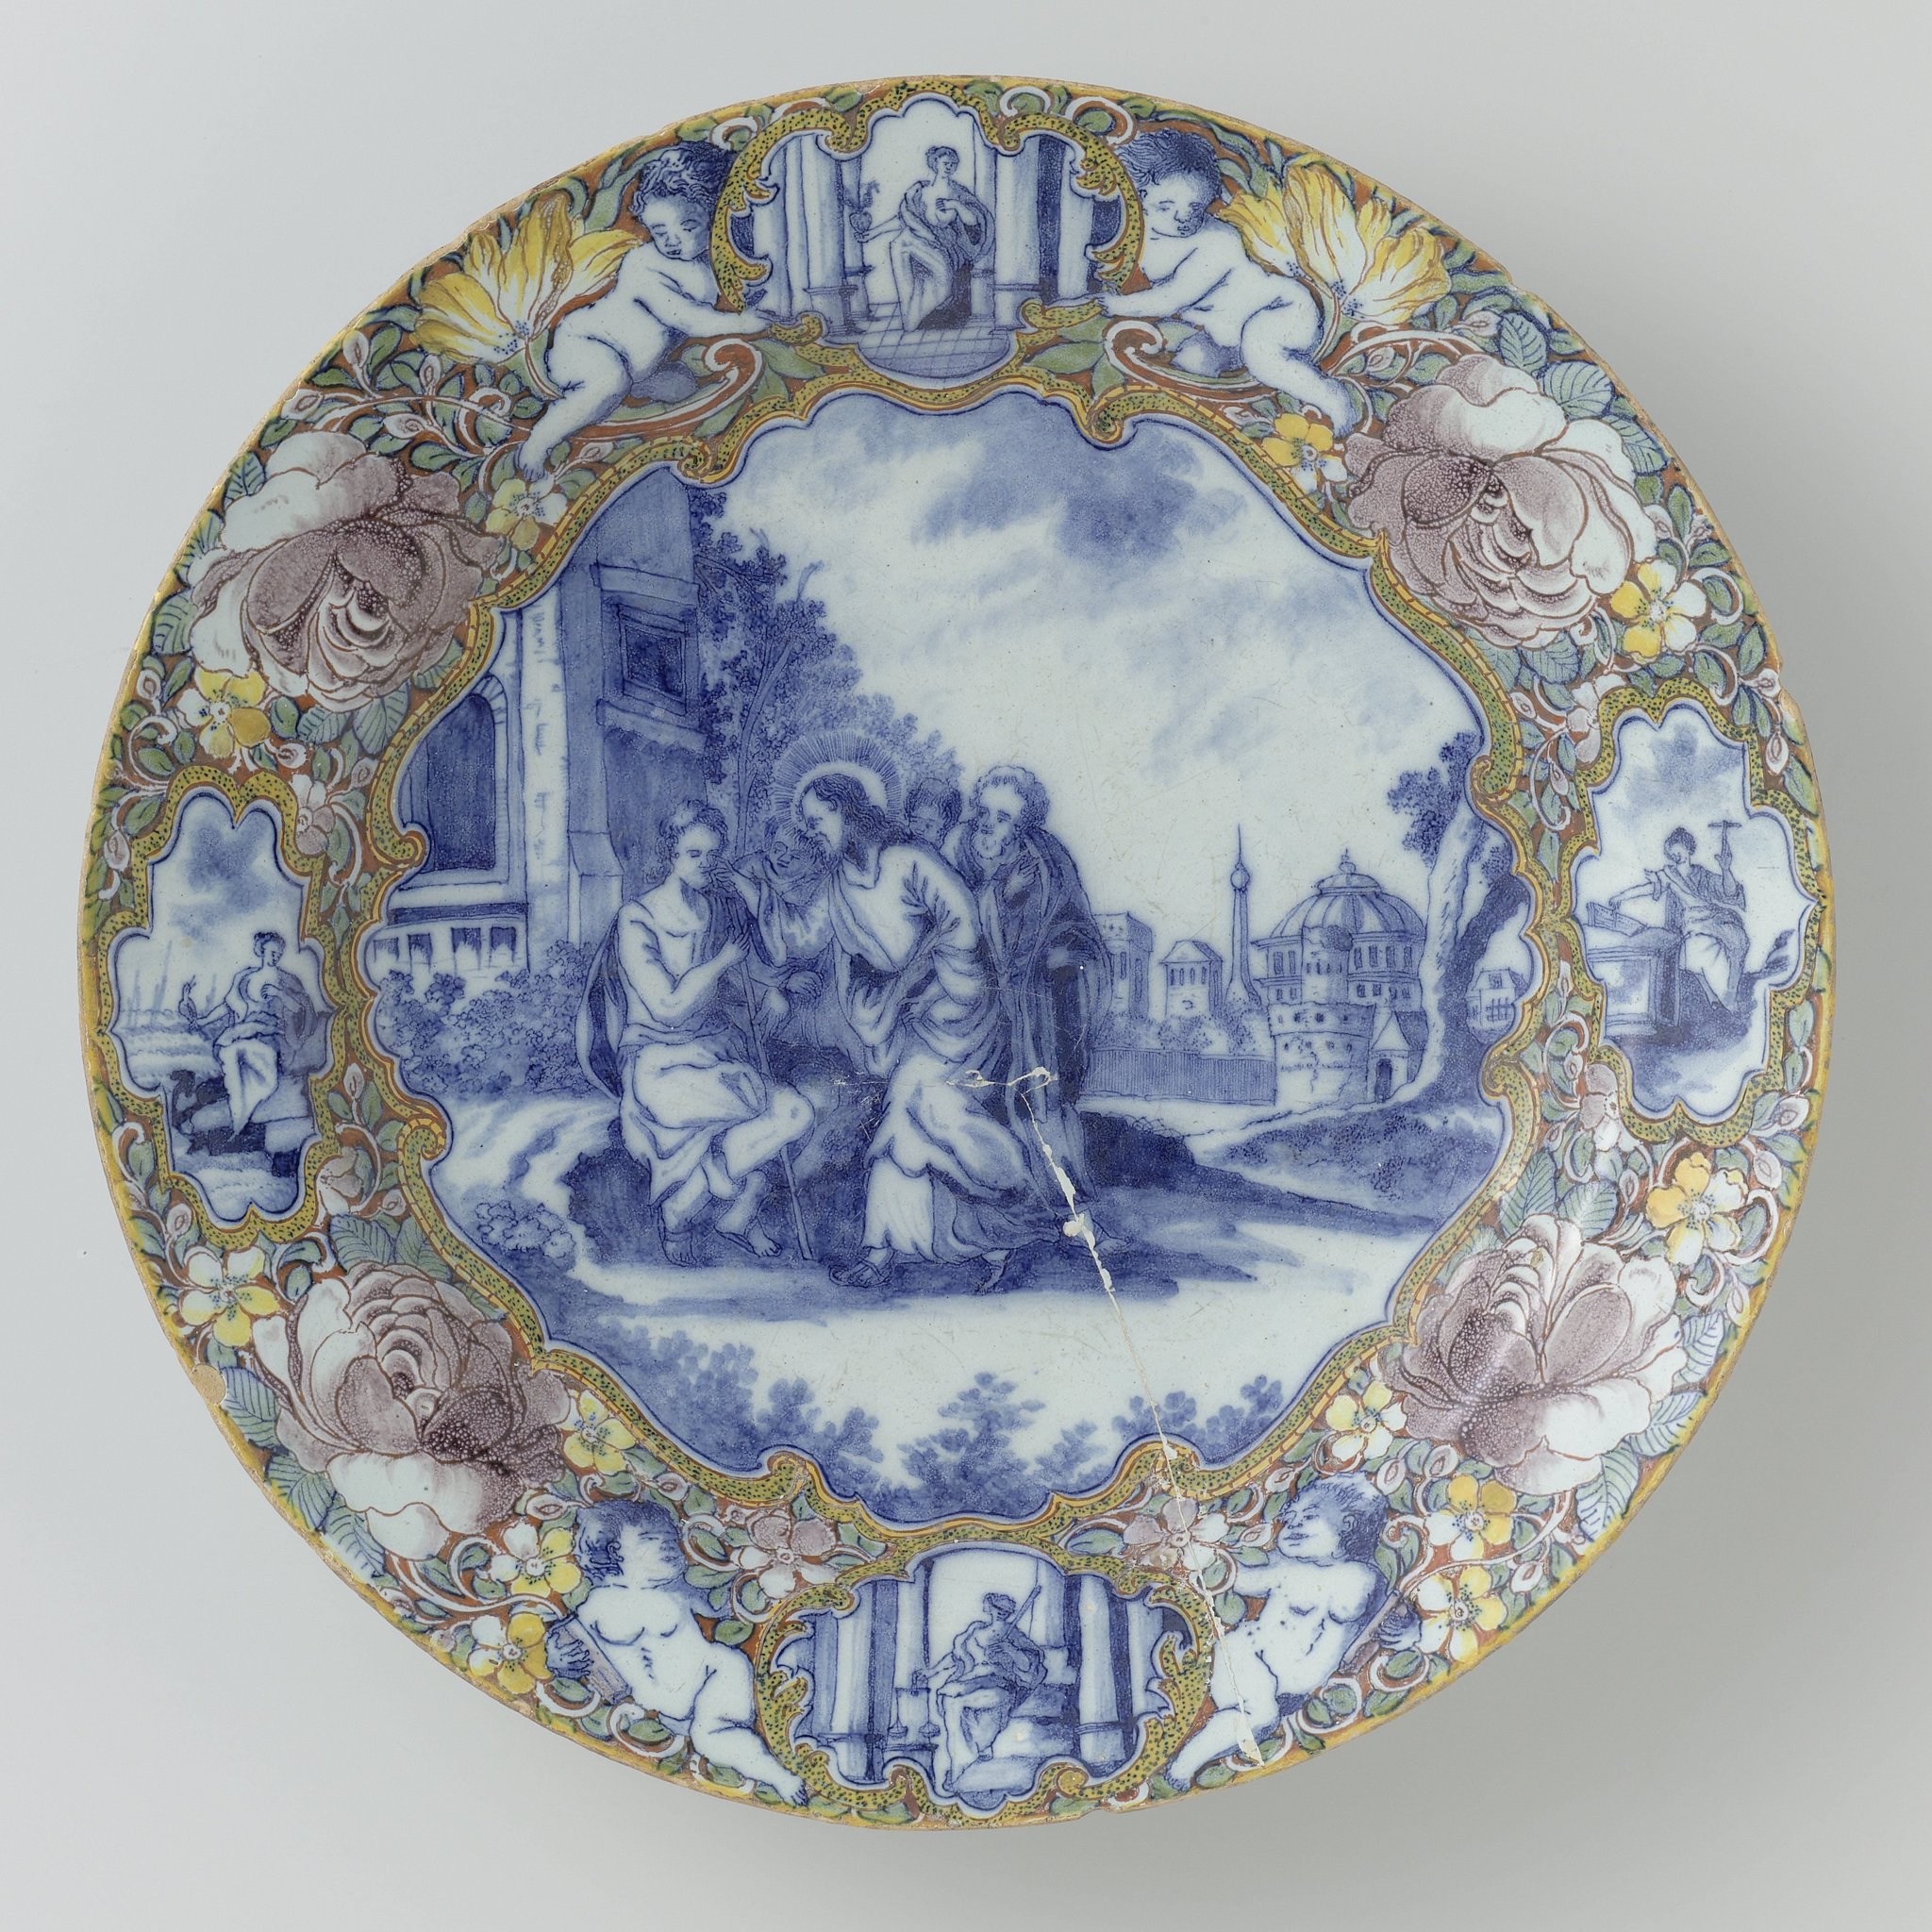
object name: platter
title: Schotel van faïence met de genezing van de blinde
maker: Anonymous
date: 1740-1775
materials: faience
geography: delft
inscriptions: collector's mark: ‘collection J.F. Loudon’, seal: ‘118’, mark: ‘figuratief teken bijltje met <’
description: Schotel van faïence. Blauw beschilderd, met de voorstelling van de Genezing van de blinde. De brede rand is veelkleurig beschilderd, in vier cartouches zijn vier Christelijke deugden afgebeeld, vermoedelijk Caritas, Fides, Justitia en Spes